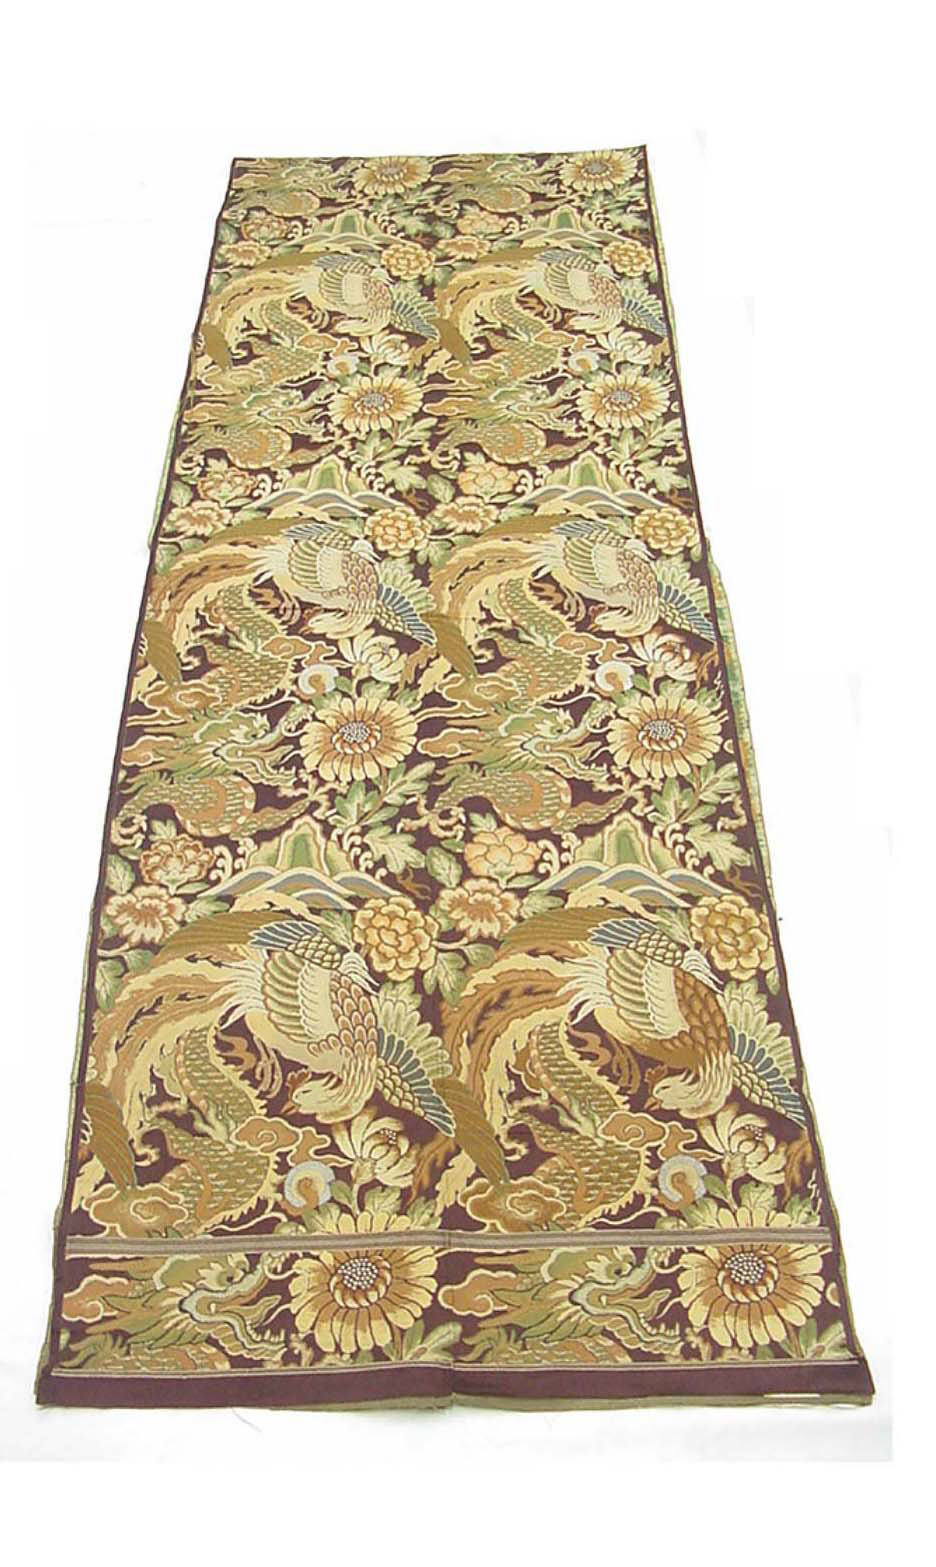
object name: obi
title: Obi with Dragon and Phoenix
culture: japanese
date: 1801-1900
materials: silk, thread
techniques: patterning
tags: birds,dragons,phoenix